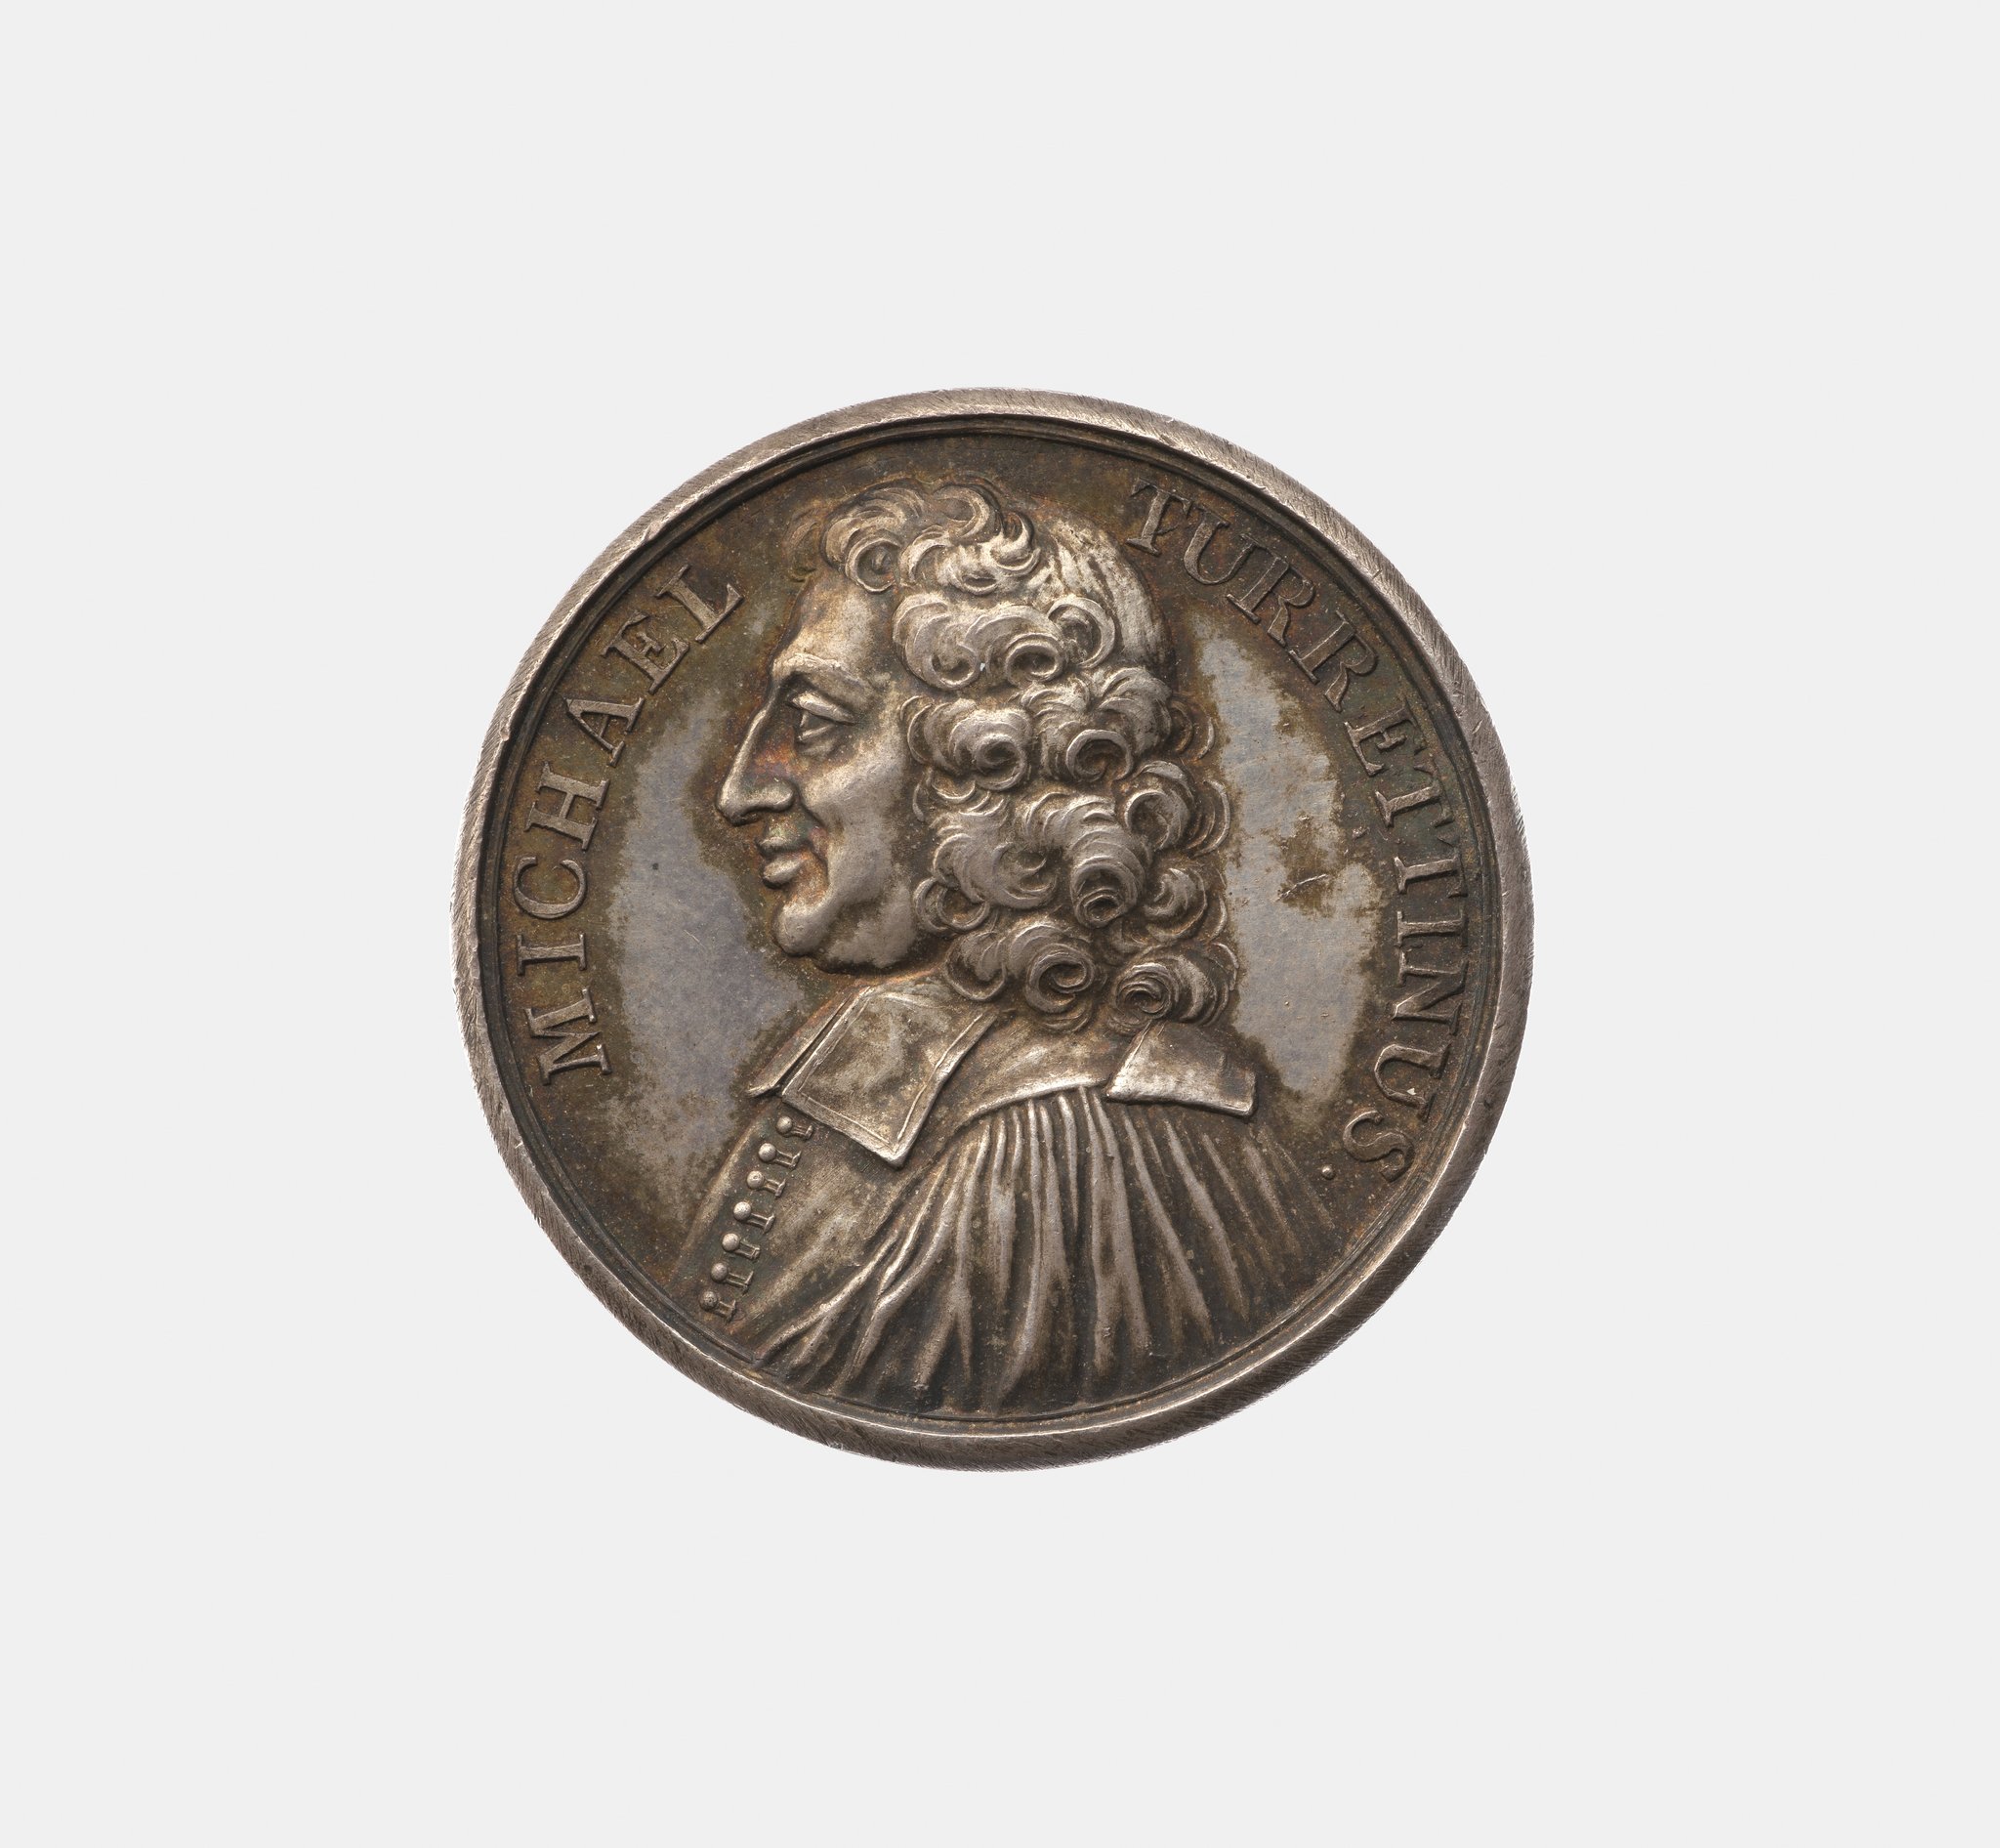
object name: medal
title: Michael Turrettini (1646–1721)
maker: jean dassier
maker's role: artist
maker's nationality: swiss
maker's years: 1676-1763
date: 1721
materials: silver